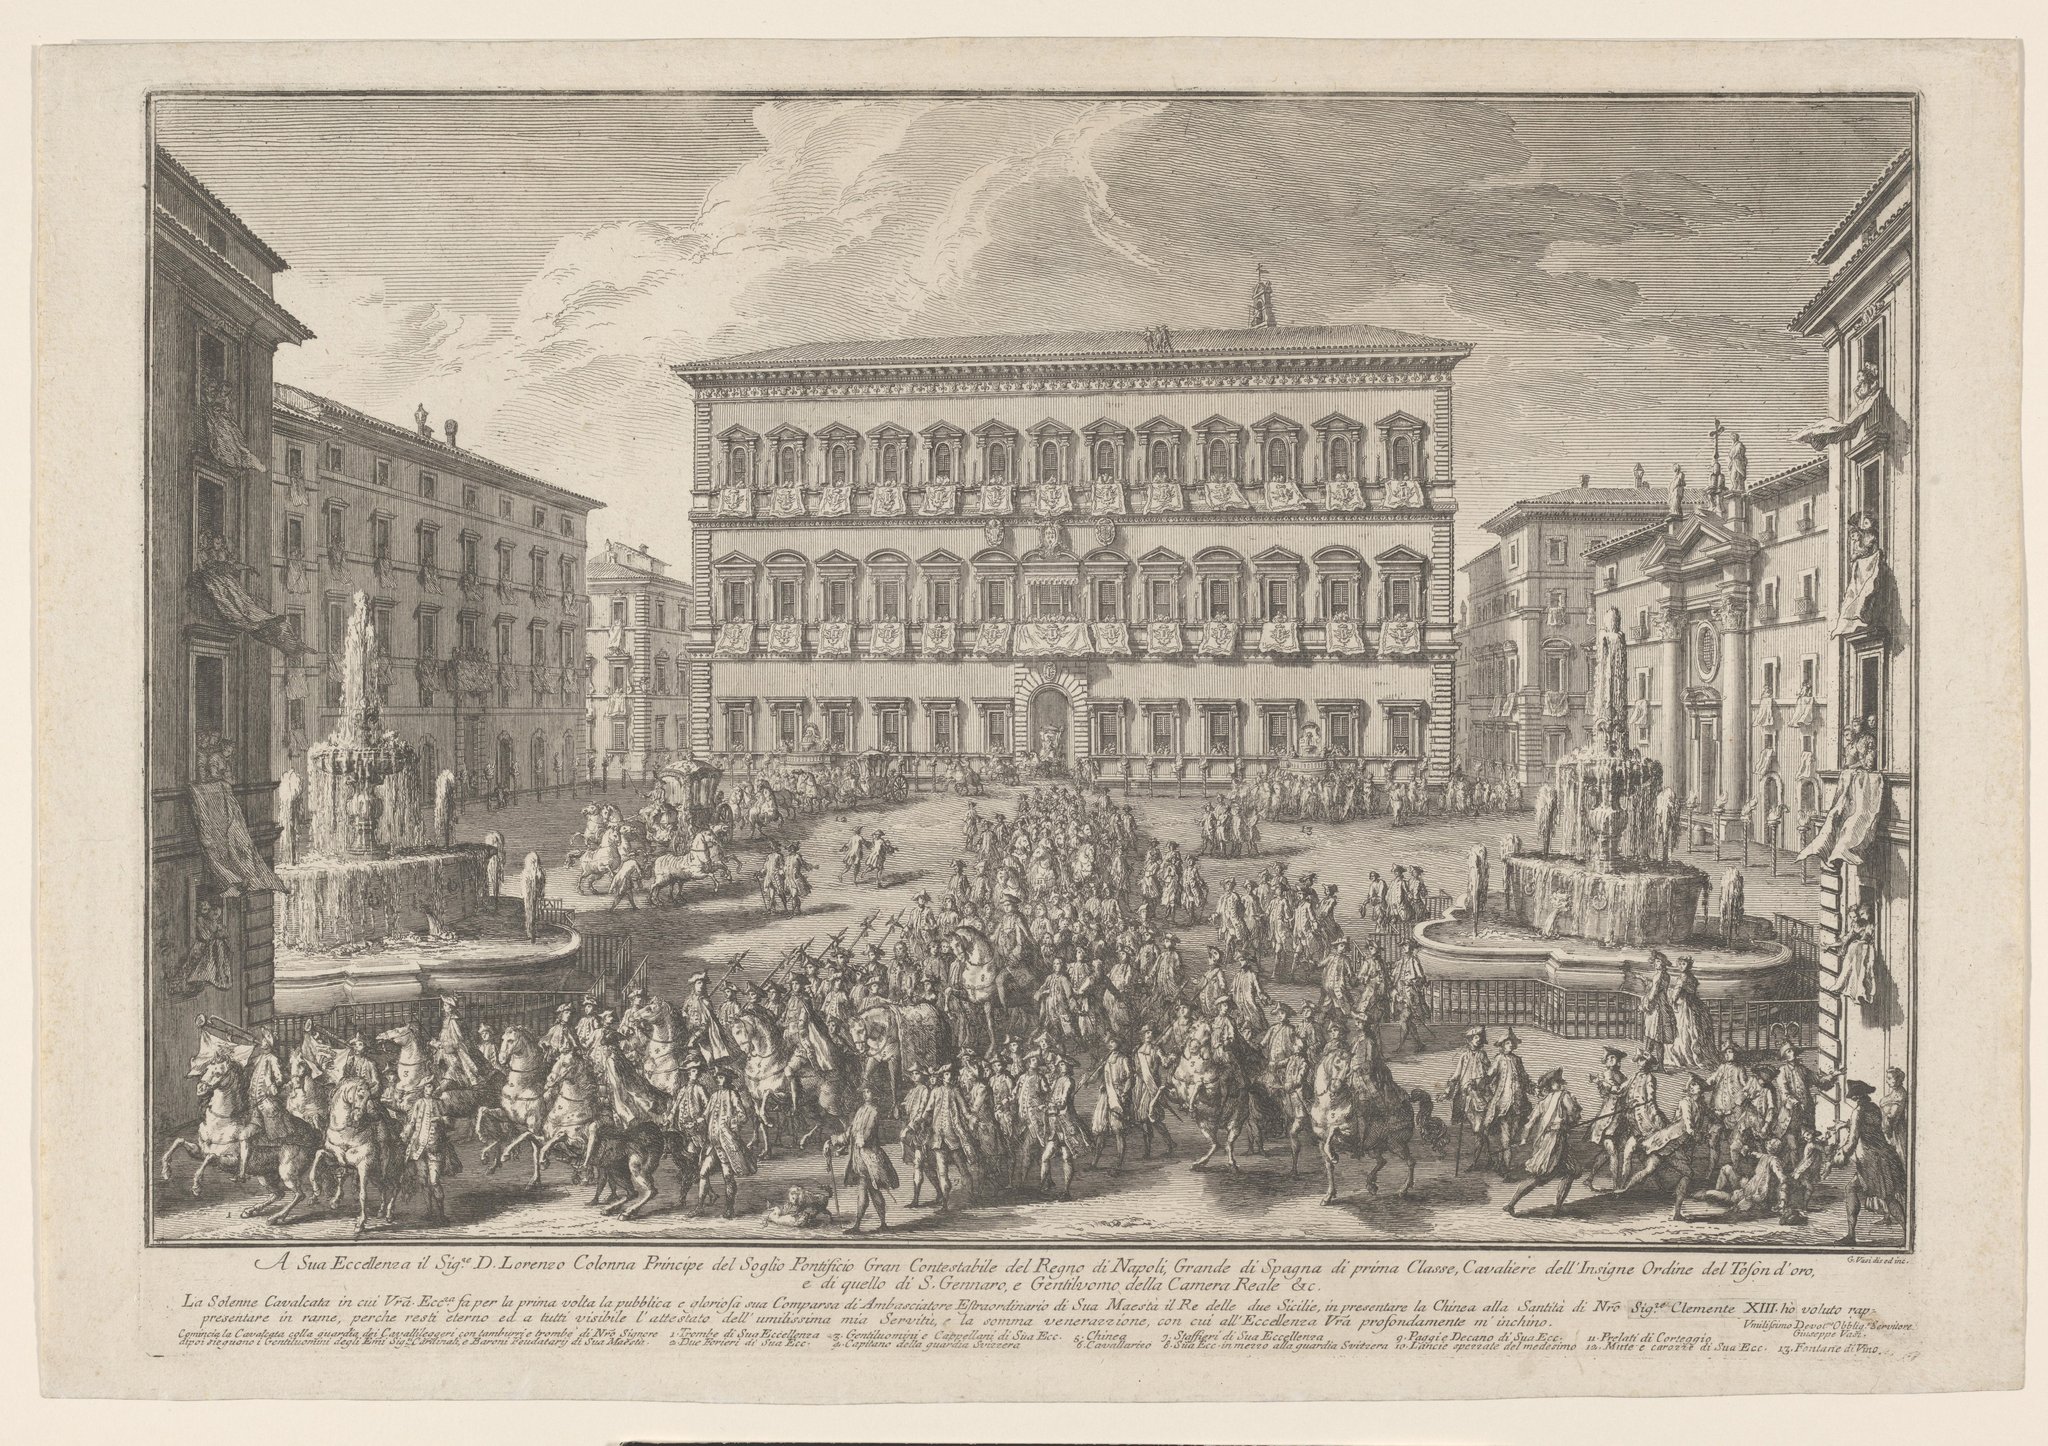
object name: print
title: Het vertrek van de Chinea festival optocht in Rome vanaf het Palazzo Farnese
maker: giuseppe vasi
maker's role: draughtsman, painter, print maker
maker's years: 1710-1782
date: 1756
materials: ink, paper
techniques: etching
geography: rome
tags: palazzo farnese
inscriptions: collector's mark: Lugt 2228, collector's mark: Lugt 2760